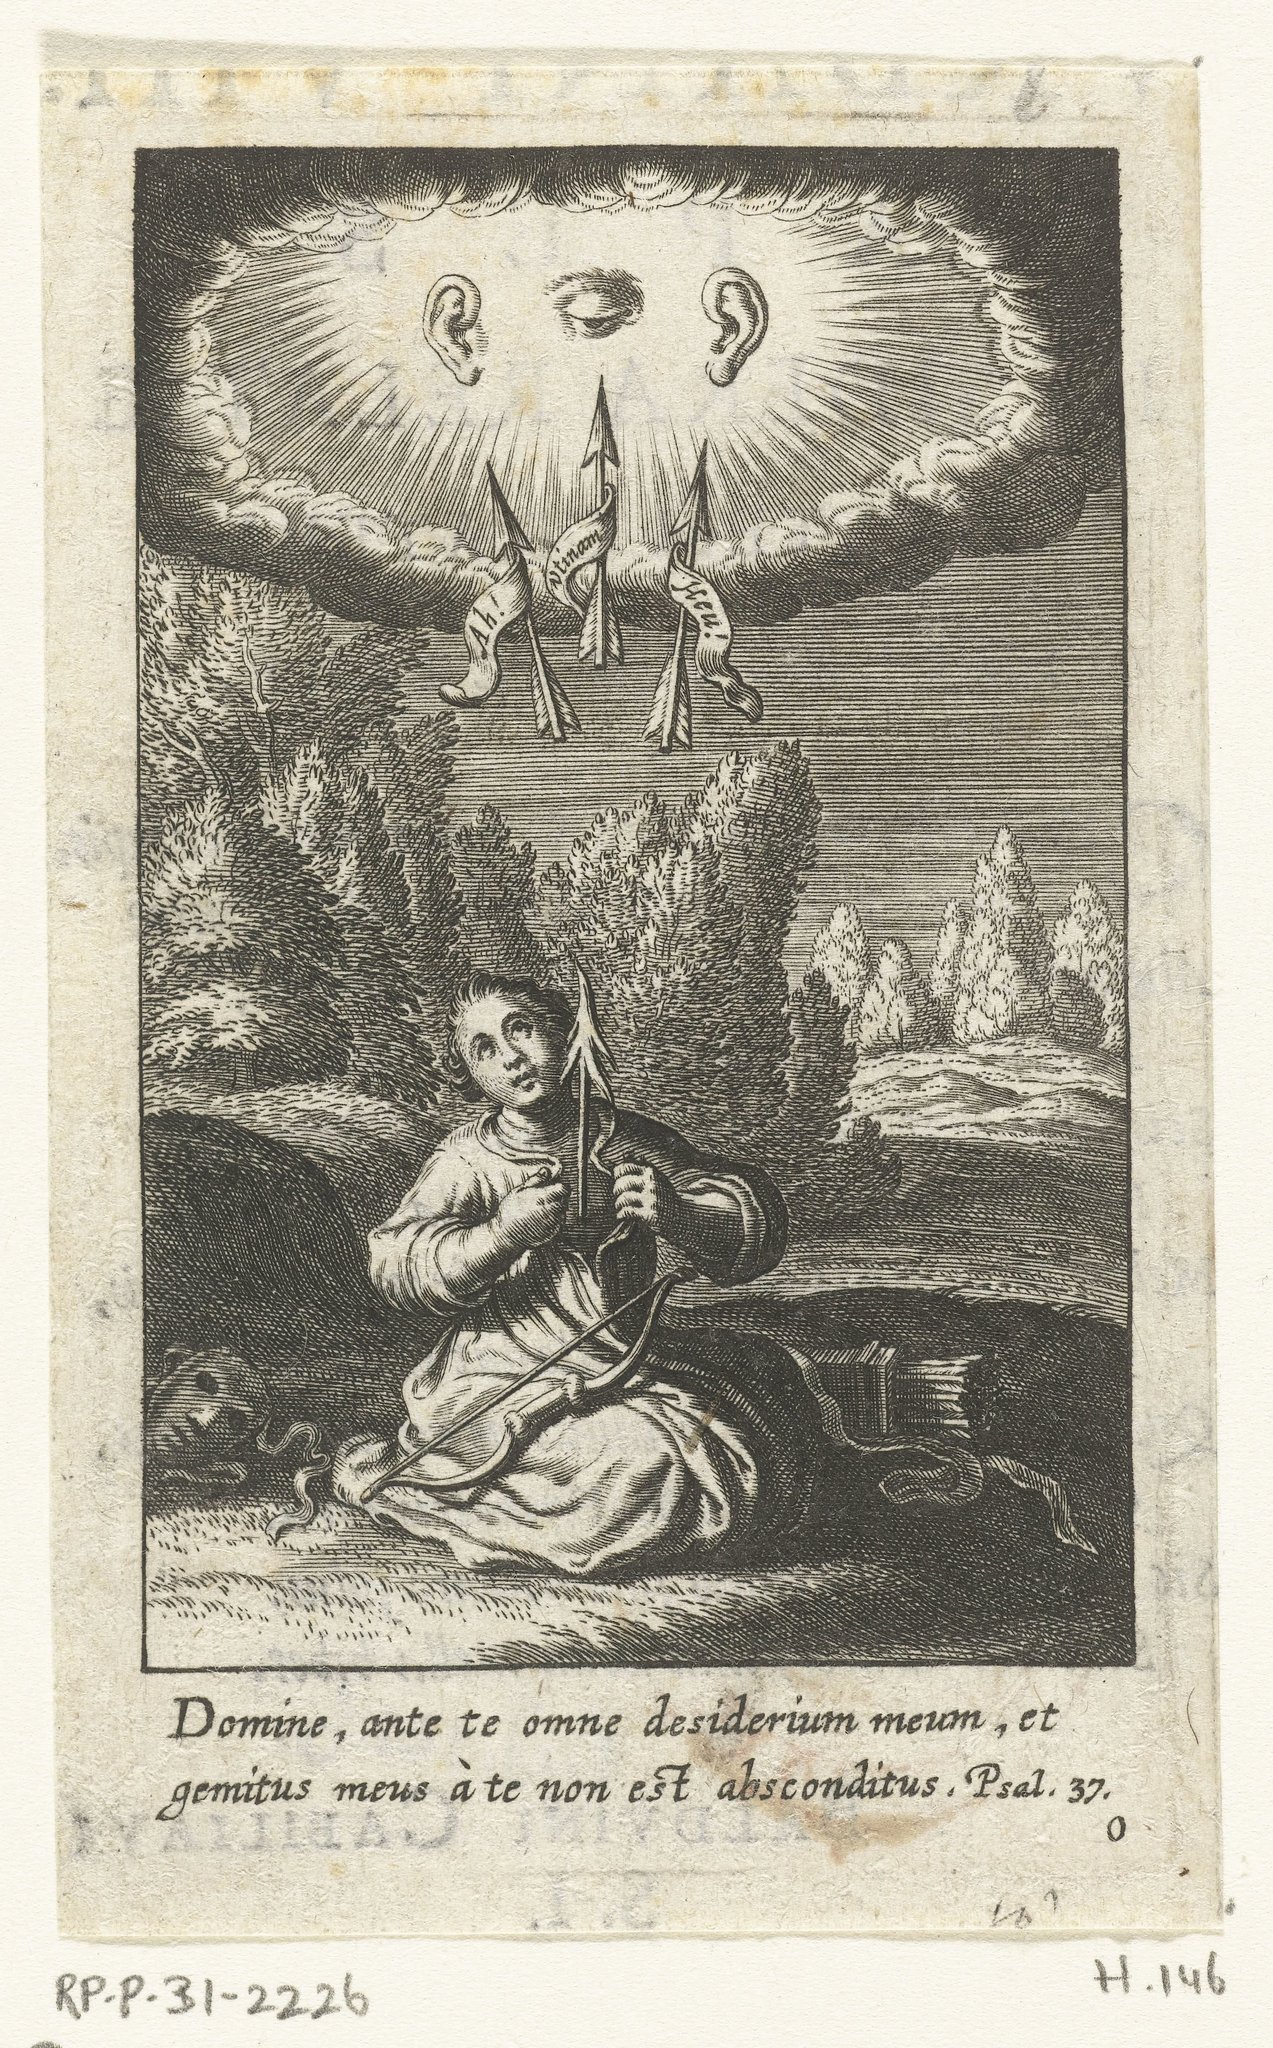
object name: print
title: Kind met pijl en boog en alziend oog van God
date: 1590-1624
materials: paper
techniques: engraving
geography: antwerp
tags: the all-seeing eye, triangle with eye ~ symbol of god the father, the worship of god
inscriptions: inscription: ‘Domine ante te omne desiderium meum, et gemitus meus à te non.o. est absconditus.’, collector's mark: Lugt 240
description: Boekillustratie uit: Herman Hugo, Pia desideria emblematis, elegiis & affectibus S. S. Patrum illustrata, Antwerpen 1624